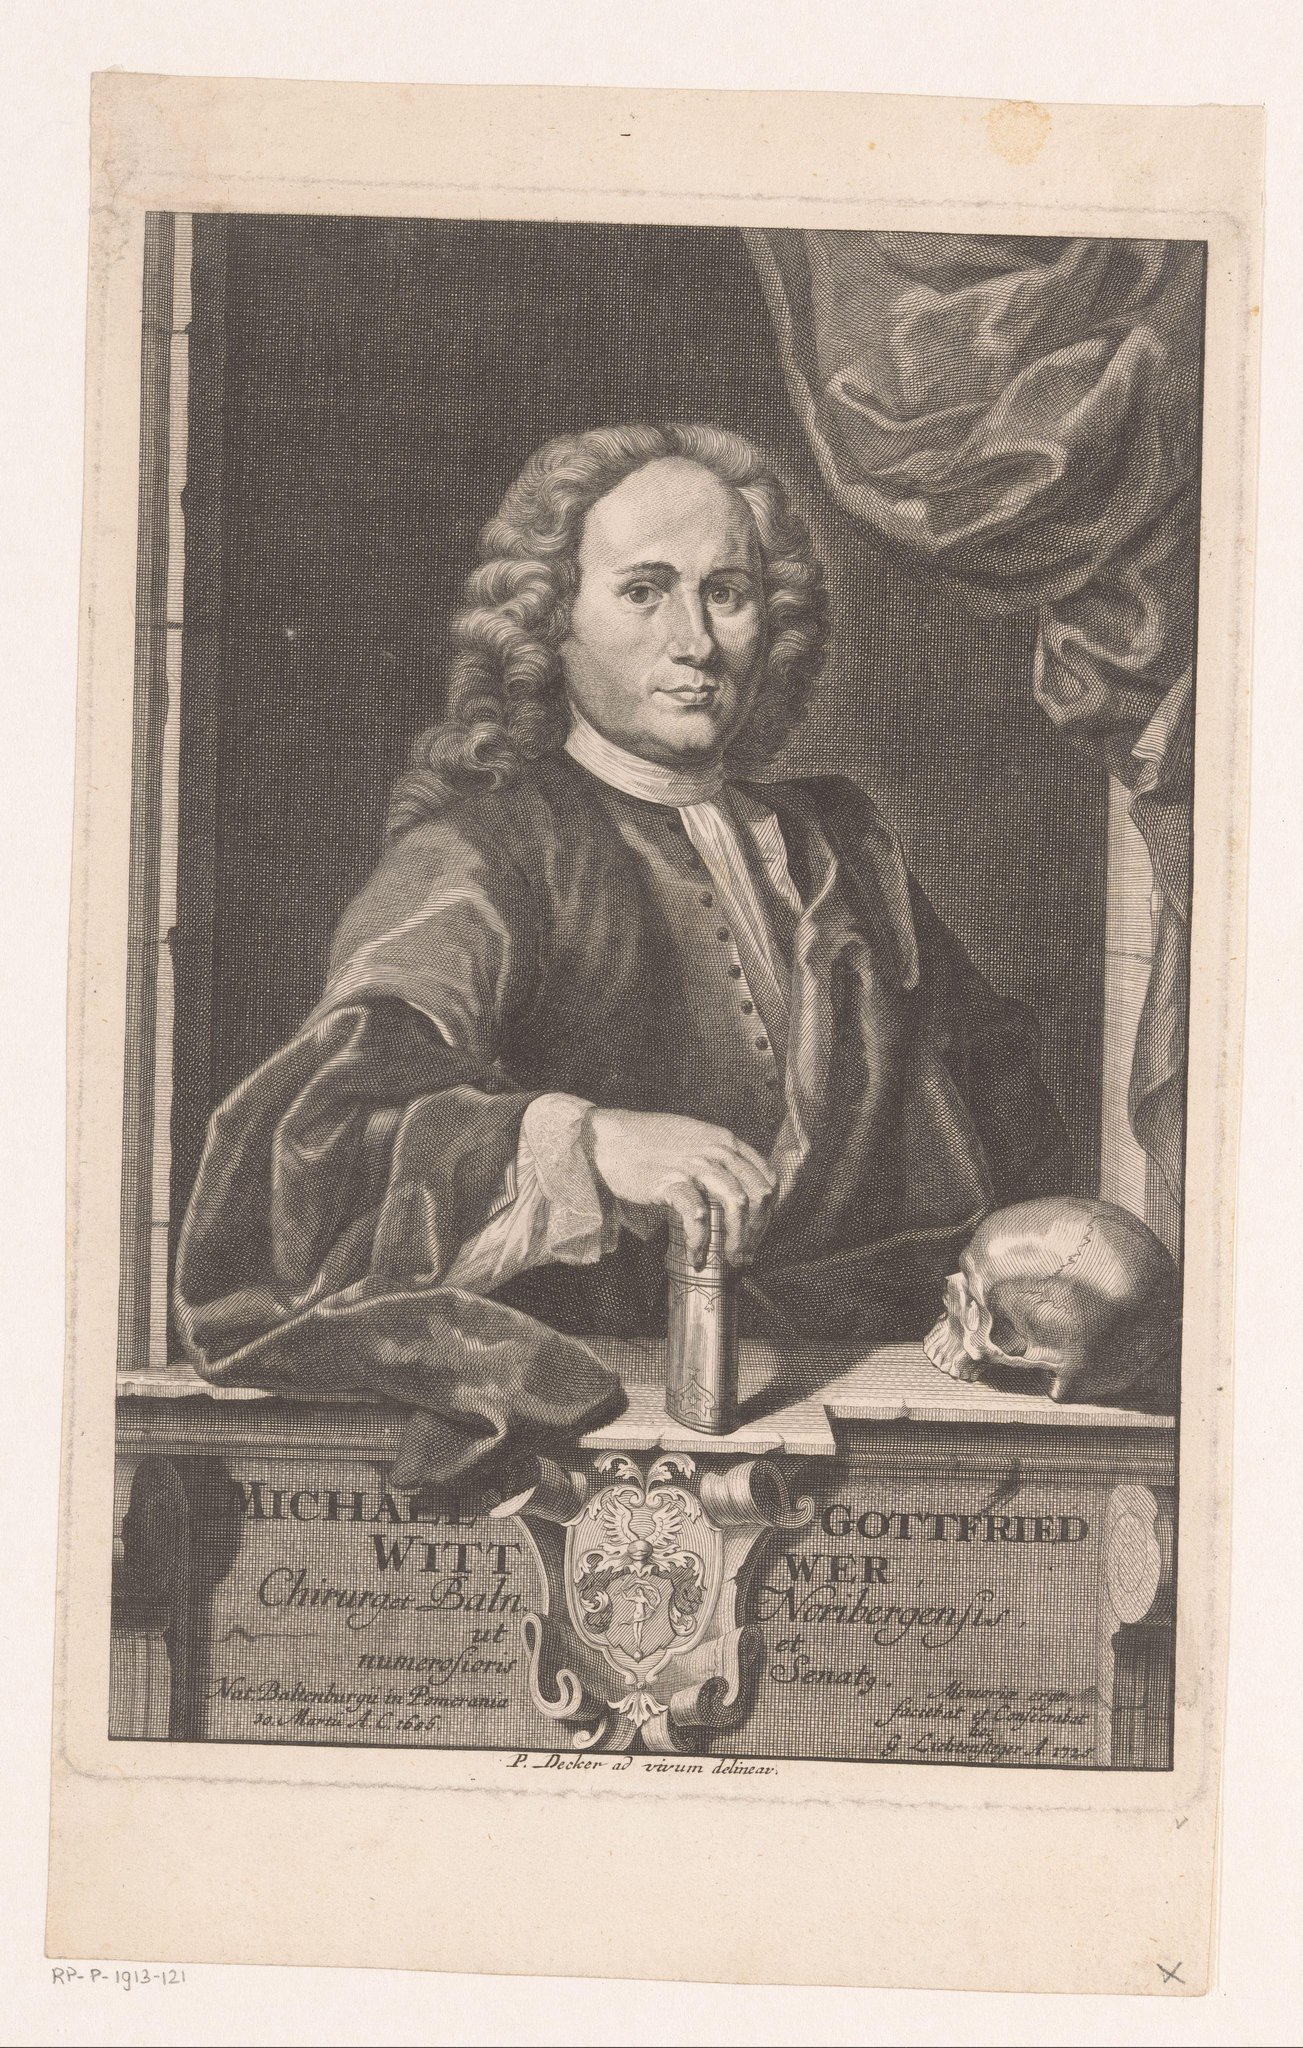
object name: print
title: Portret van Michael Gottfried Wittwer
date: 1725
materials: paper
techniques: engraving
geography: nuremberg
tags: historical persons, armorial bearing, heraldry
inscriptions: collector's mark: Lugt 2228